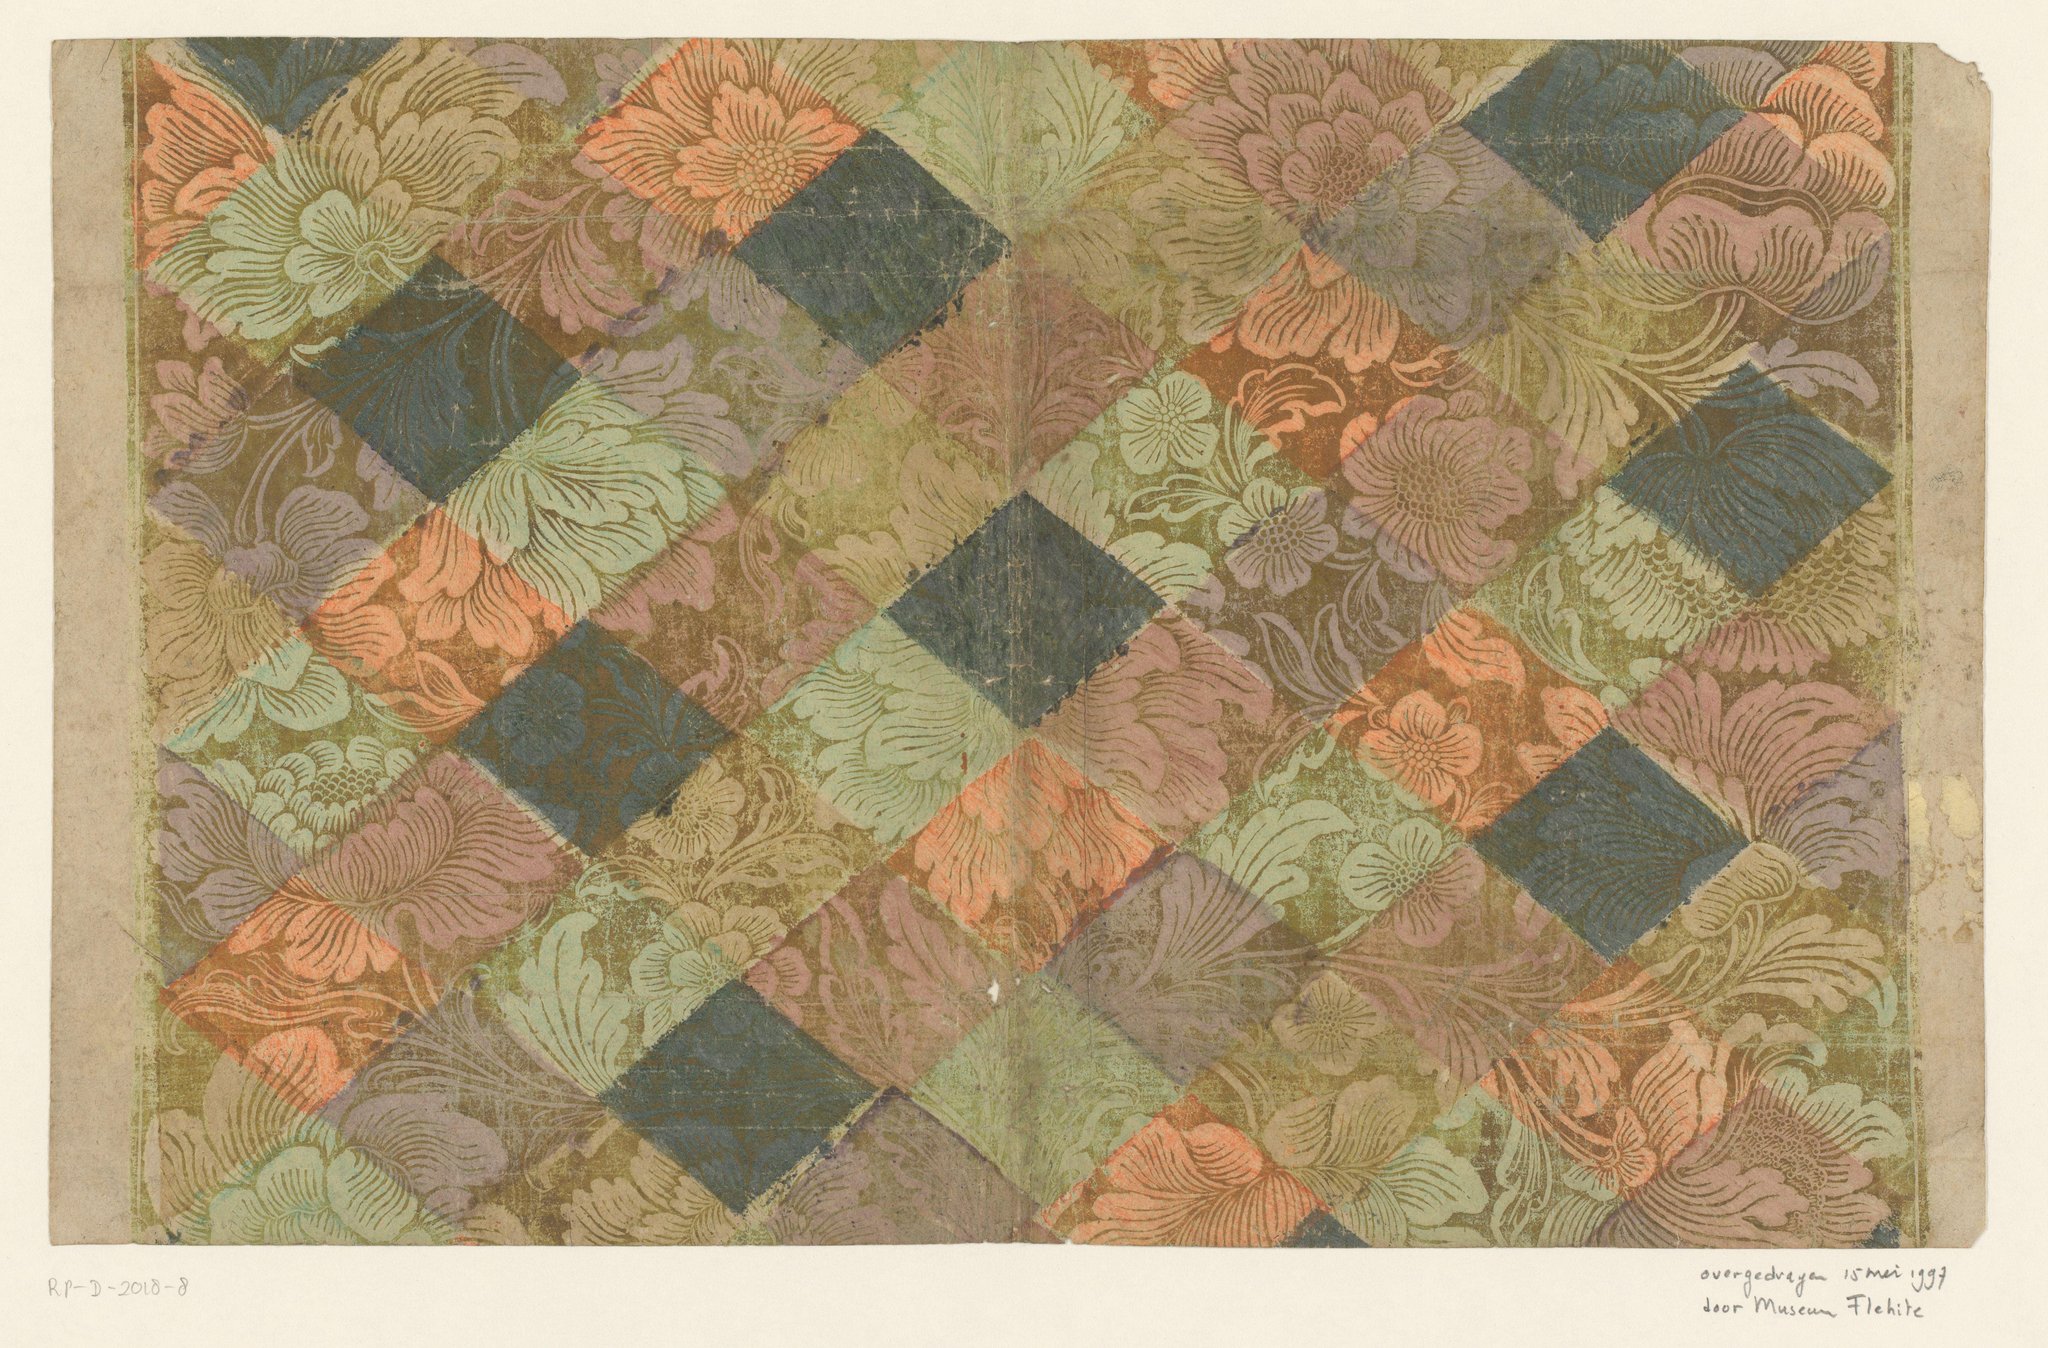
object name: wrapper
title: Blad met bloemen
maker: Anonymous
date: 1750-1820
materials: gold leaf, paint, paper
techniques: relief print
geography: germany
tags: ornament derived from plant forms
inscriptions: collector's mark: Lugt 2228